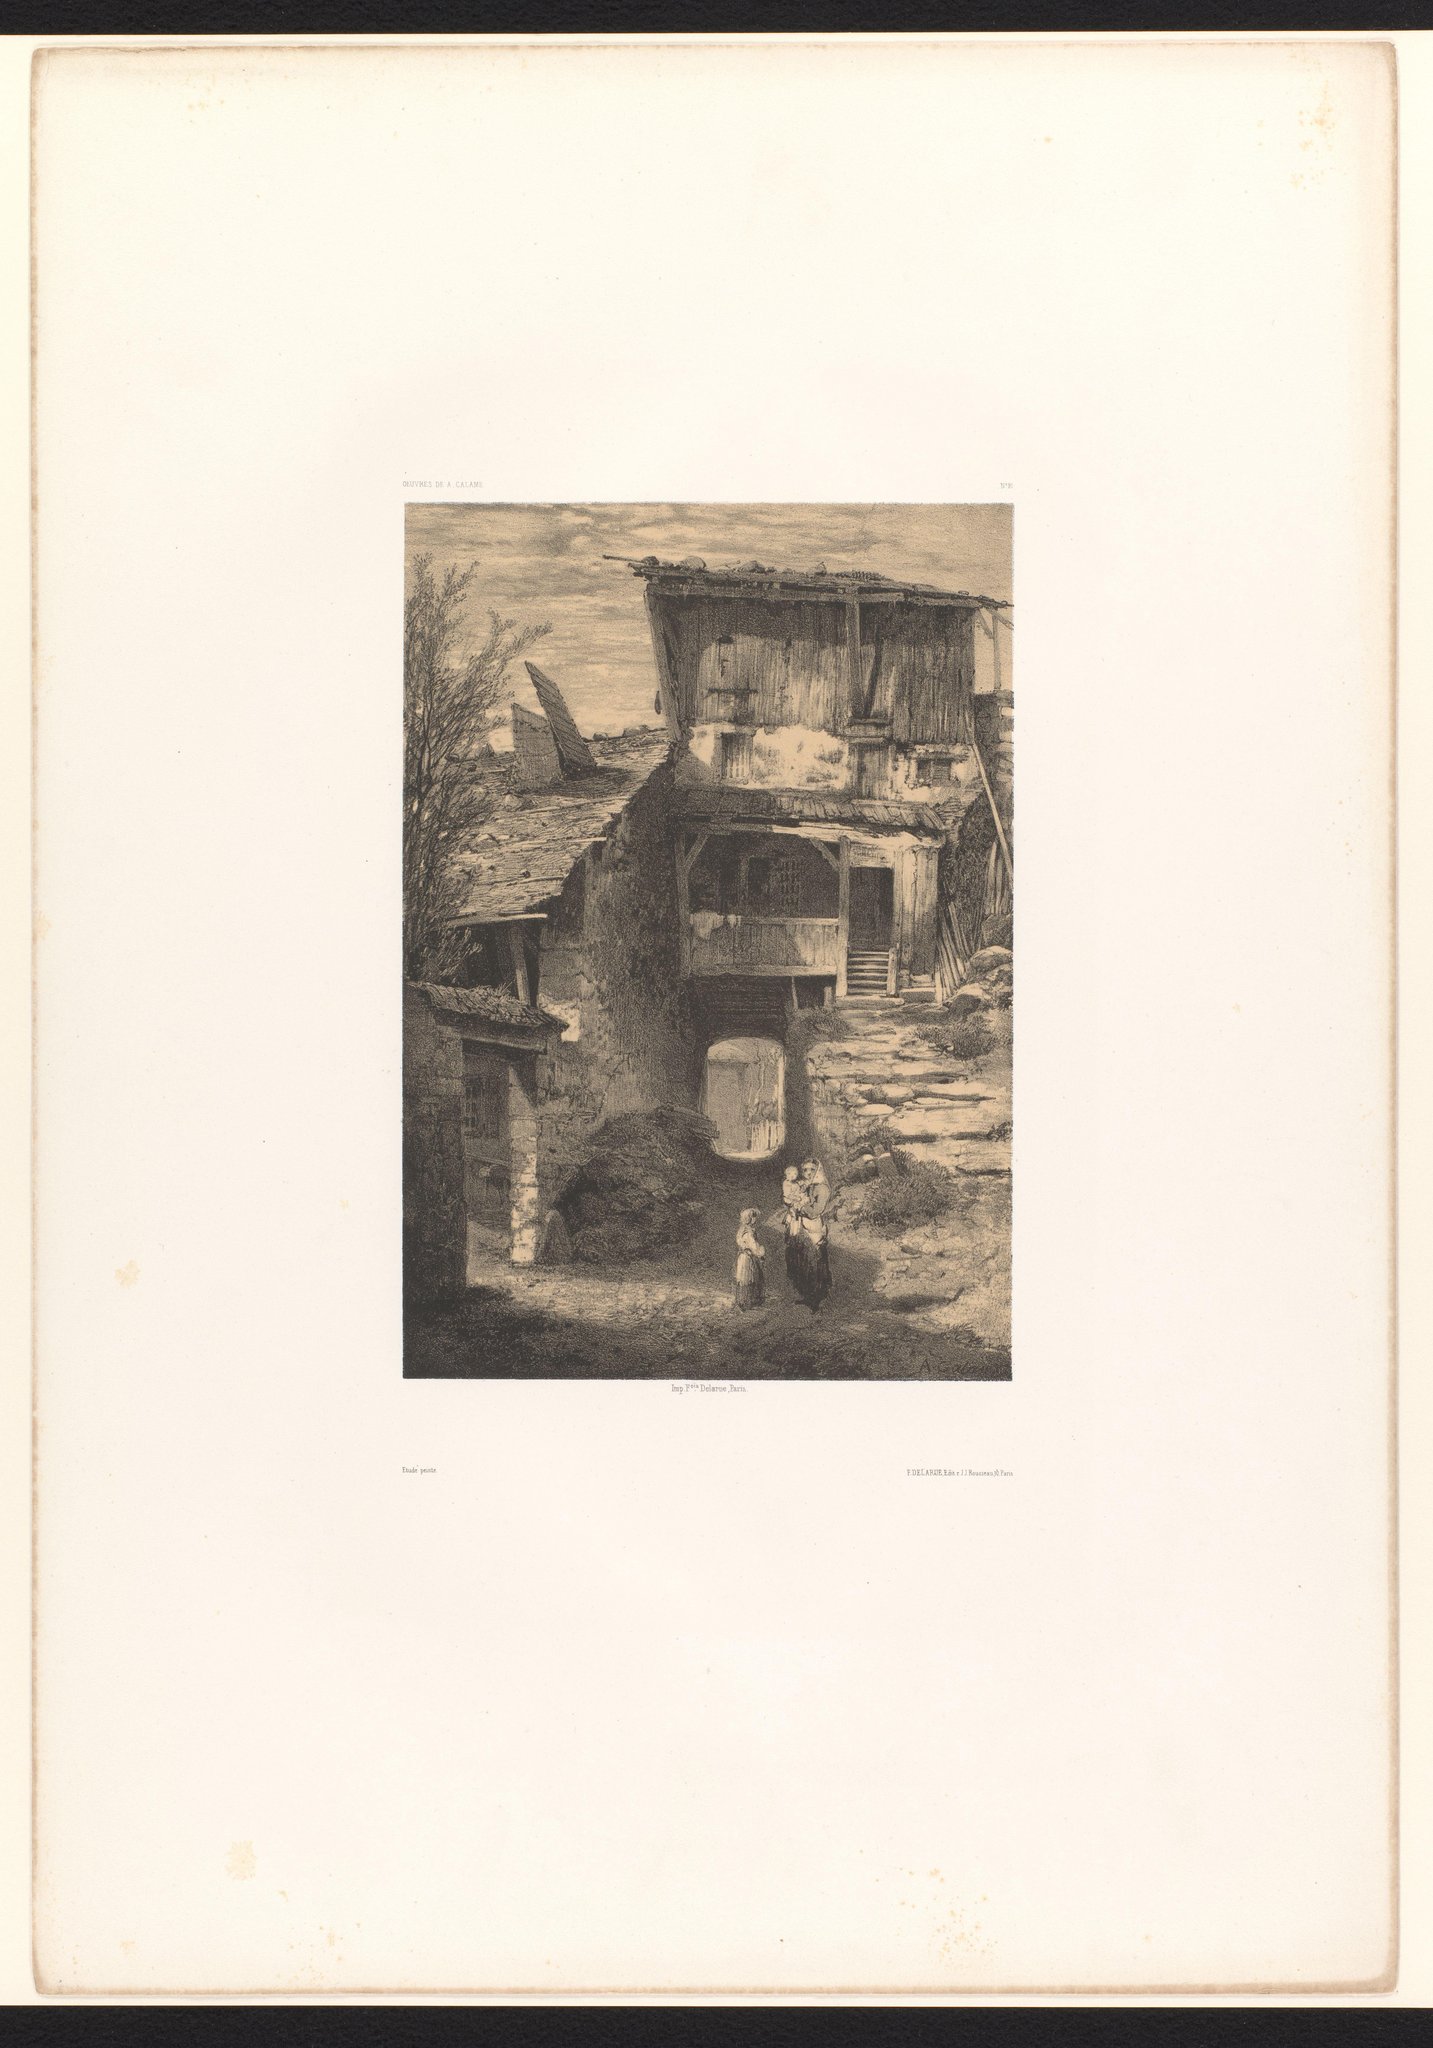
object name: print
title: Moeder met twee kinderen bij huizen in bergachtig gebied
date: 1852-1855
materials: paper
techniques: lithograph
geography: paris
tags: rural housing, e.g. country-house, villa, cottage, mother and child(ren), woman and child(ren) (family group)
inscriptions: collector's mark: Lugt 2228a